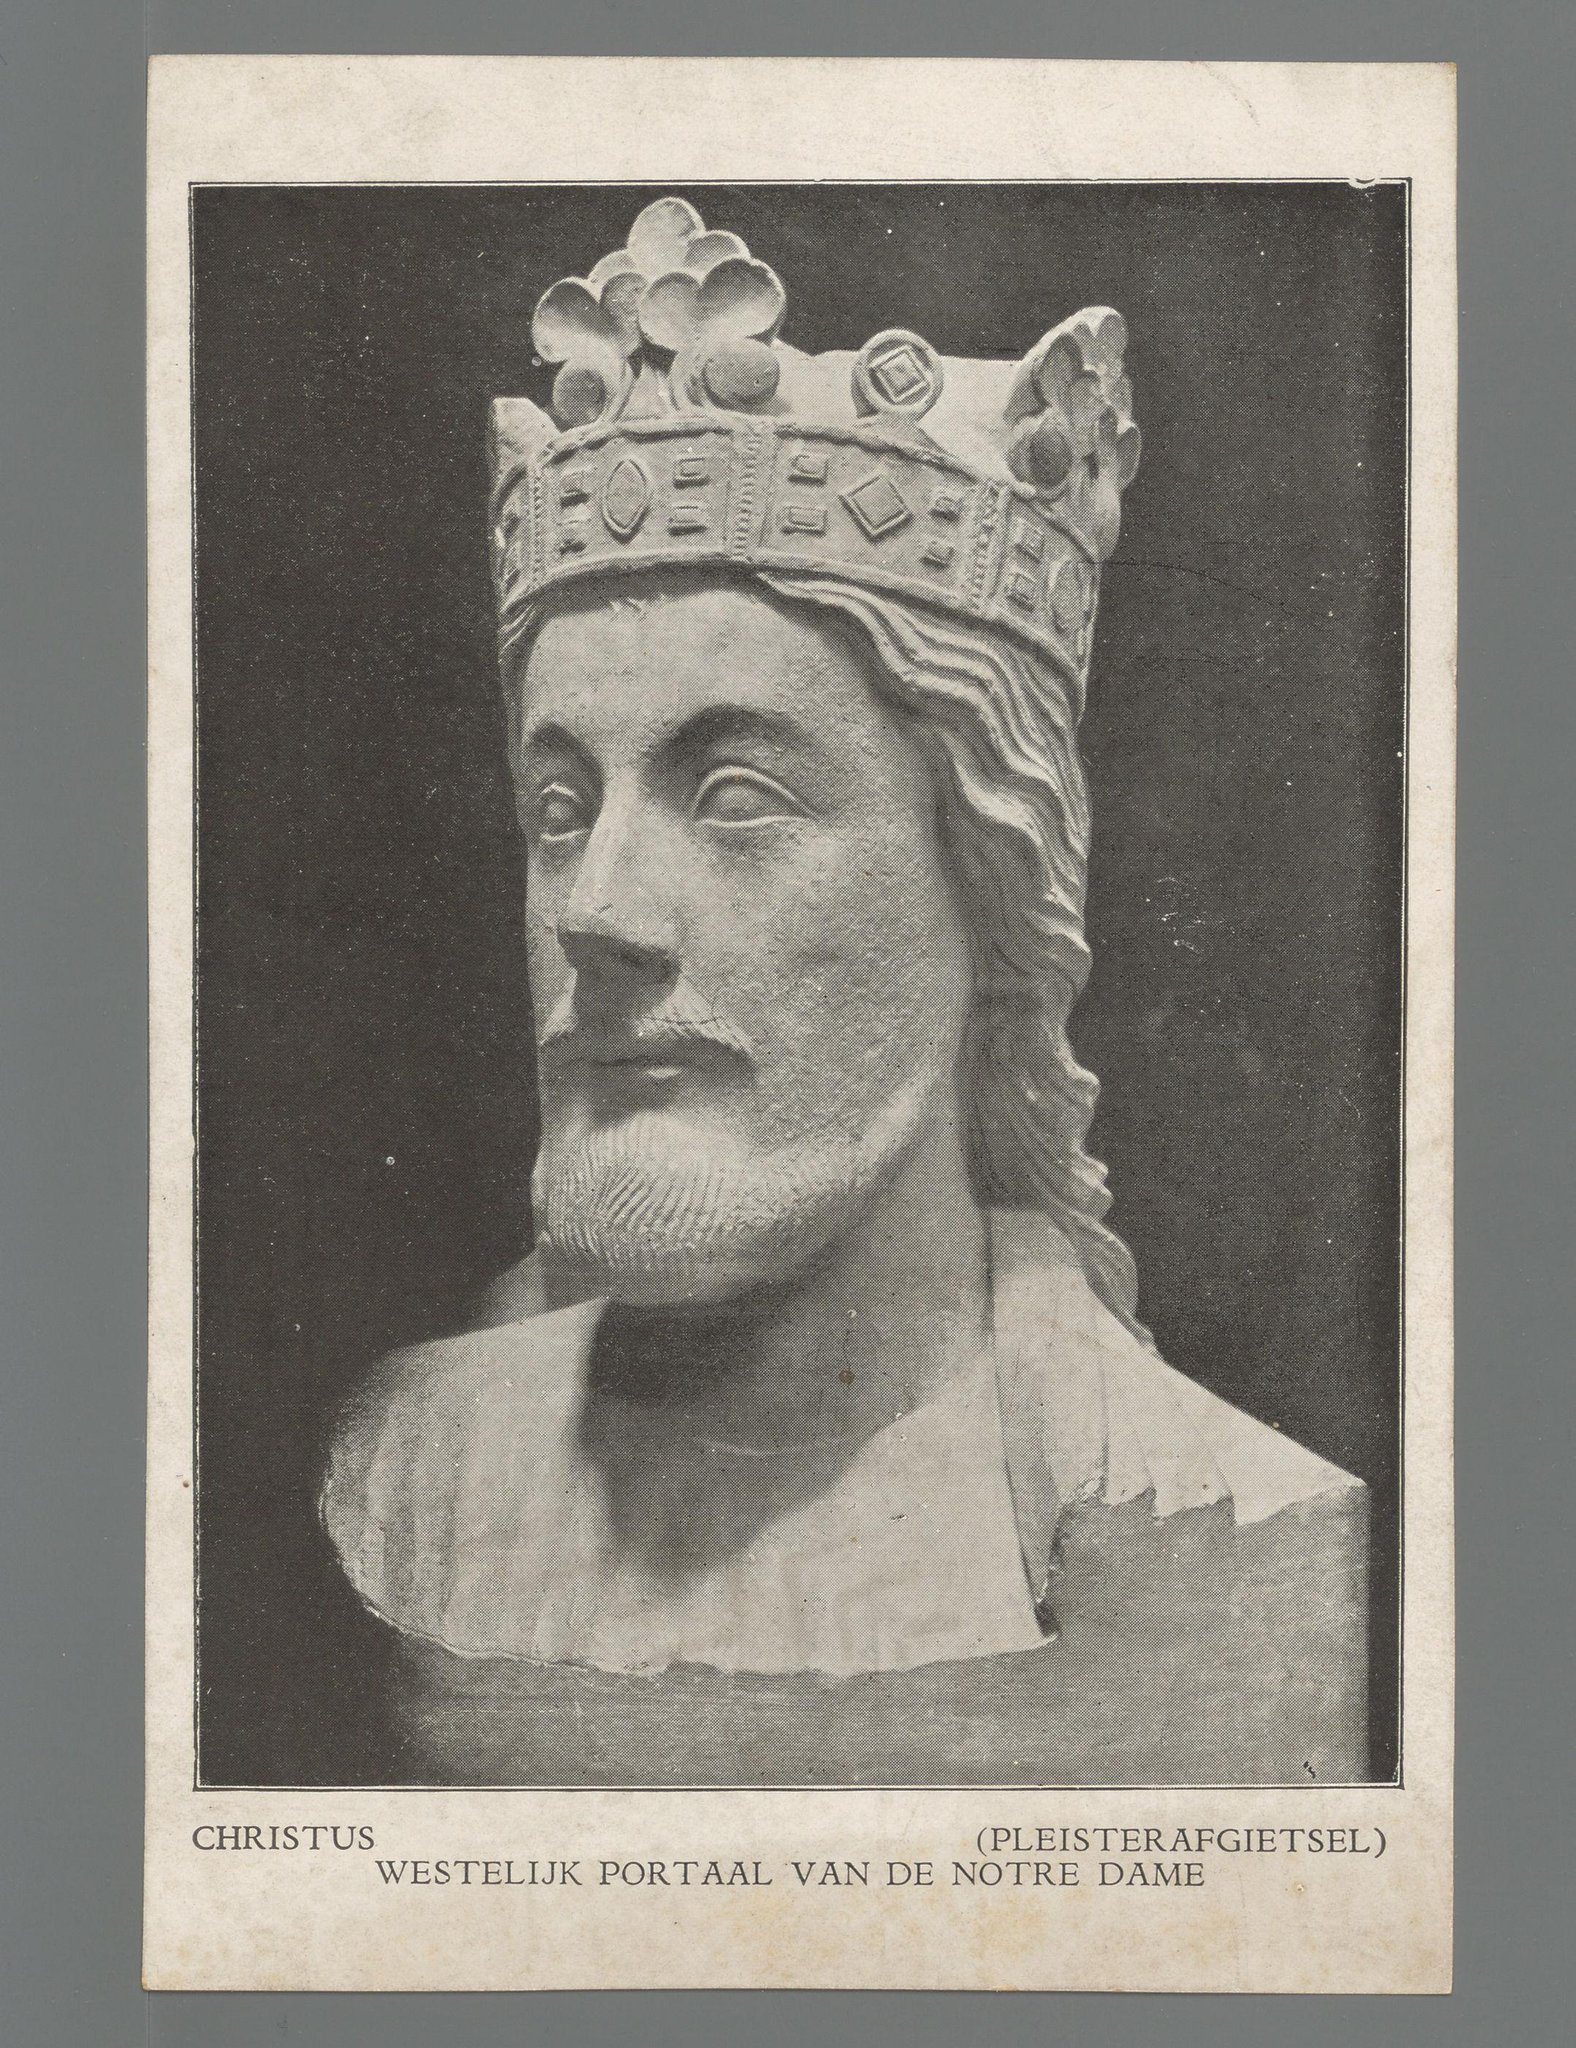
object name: ansichtkaart, prentbriefkaart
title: Christus (pleisterafgietsel). Westelijk Portaal van de Notre Dame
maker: Anonymous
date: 1925-1926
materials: cardboard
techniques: autotype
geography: amsterdam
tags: christ as adult, sculpture